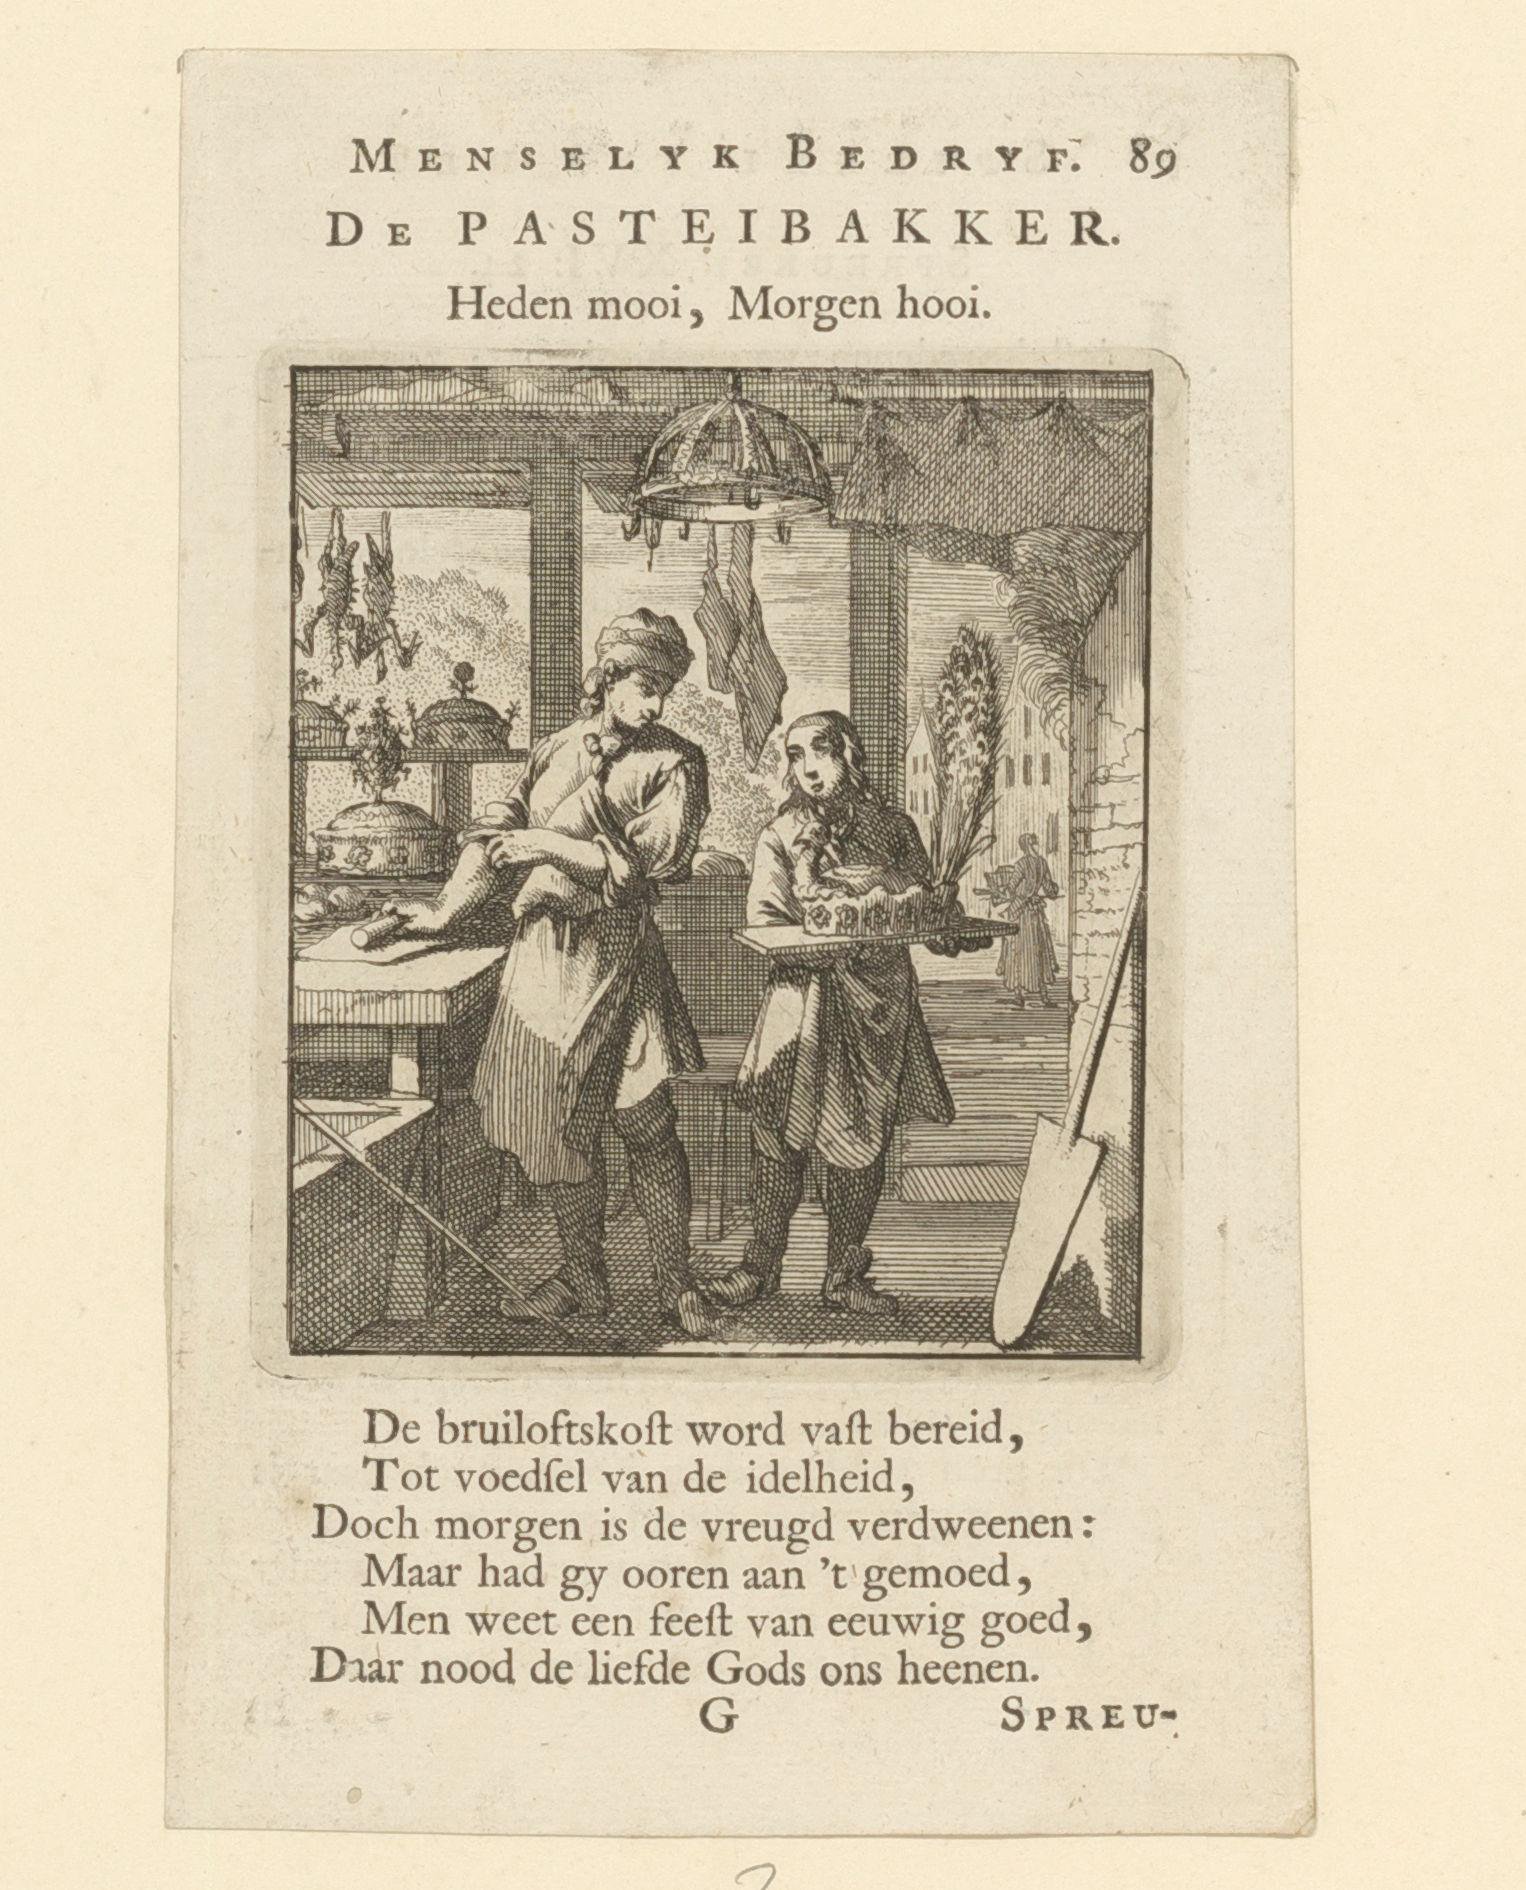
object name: print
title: Pasteibakker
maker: cornelis van der sys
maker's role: publisher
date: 1718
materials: paper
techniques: etching, letterpress printing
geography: amsterdam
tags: pie, handicrafts, craftsman at work, baker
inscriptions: collector's mark: Lugt 1641, stamp, stamp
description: Prent oorspronkelijk verschenen in de 100-delige serie beroepsprenten van Jan en Caspar Luyken, getiteld: Het menselyk bedryf. S.l.s.n., 1694 (eerste druk). Daarna is de titel en het vers afgesneden. De prenten in diverse publicaties verschenen en gekopieerd. Huidige staat uit: Luyken, Jan en Caspar. Spiegel van het menselyk bedryf (...). Amsterdam: Cornelis van der Sys, 1718. Prent waarschijnlijk ook gebruikt in eerdere (1704) en latere (1730, 1749, 1767) publicaties.